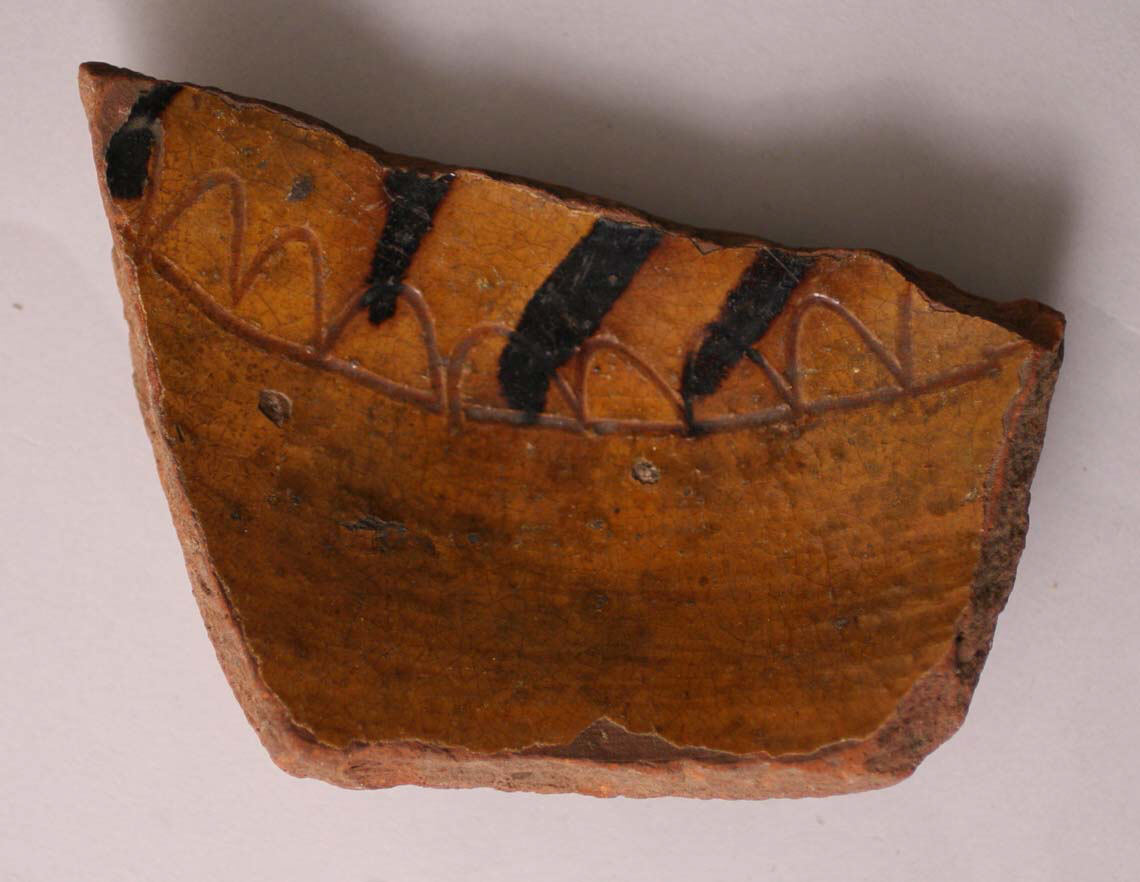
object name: ceramic fragment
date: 1301-1500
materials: earthenware, glaze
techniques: coloring, incising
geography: egypt